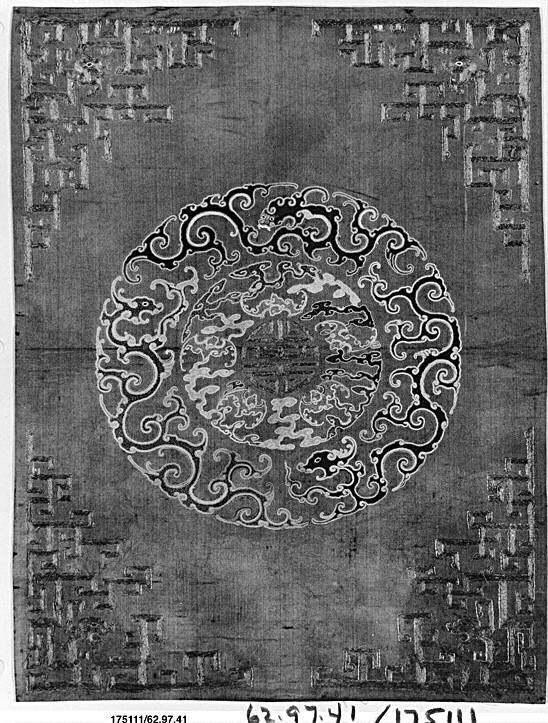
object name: furniture cover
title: Furniture Cover for Chair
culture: chinese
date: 1662-1722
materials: linen, metal thread, silk